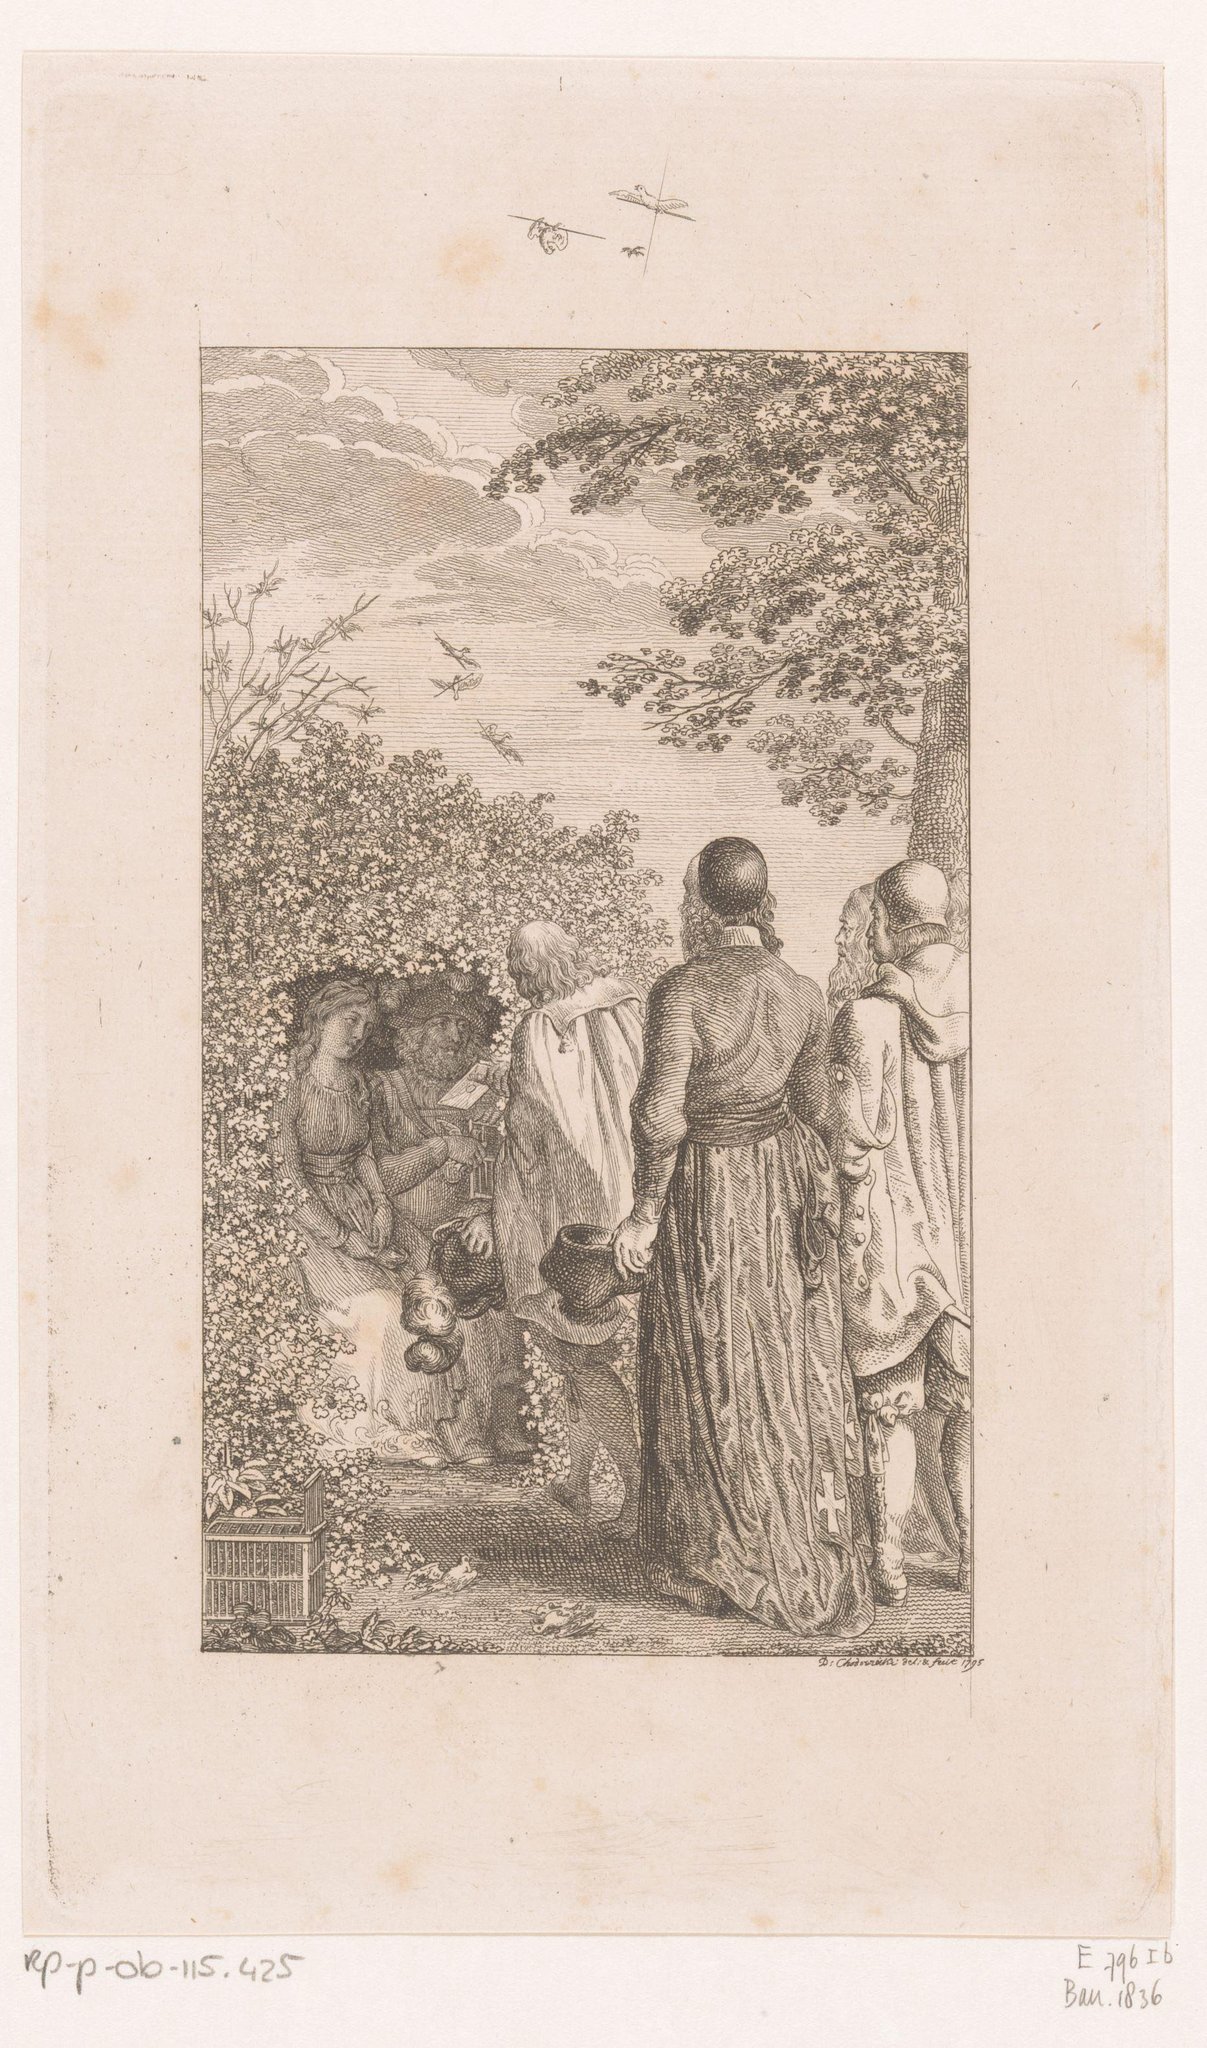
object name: print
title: Hendrik I ontvangt de broer van de overleden koning Koenraad I in zijn tuin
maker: daniel nikolaus chodowiecki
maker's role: draughtsman, print maker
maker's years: 1726-1801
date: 1795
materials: paper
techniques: etching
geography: berlin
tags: empty bird cage, history, shrubs, garden, bird hunting, ruler, sovereign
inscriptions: collector's mark: Lugt 2228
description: Prent gebruikt voor: Deutsche Monatsschrift (...). 3 dln. Leipzig: Sommersche Buchhandlung, 1795.